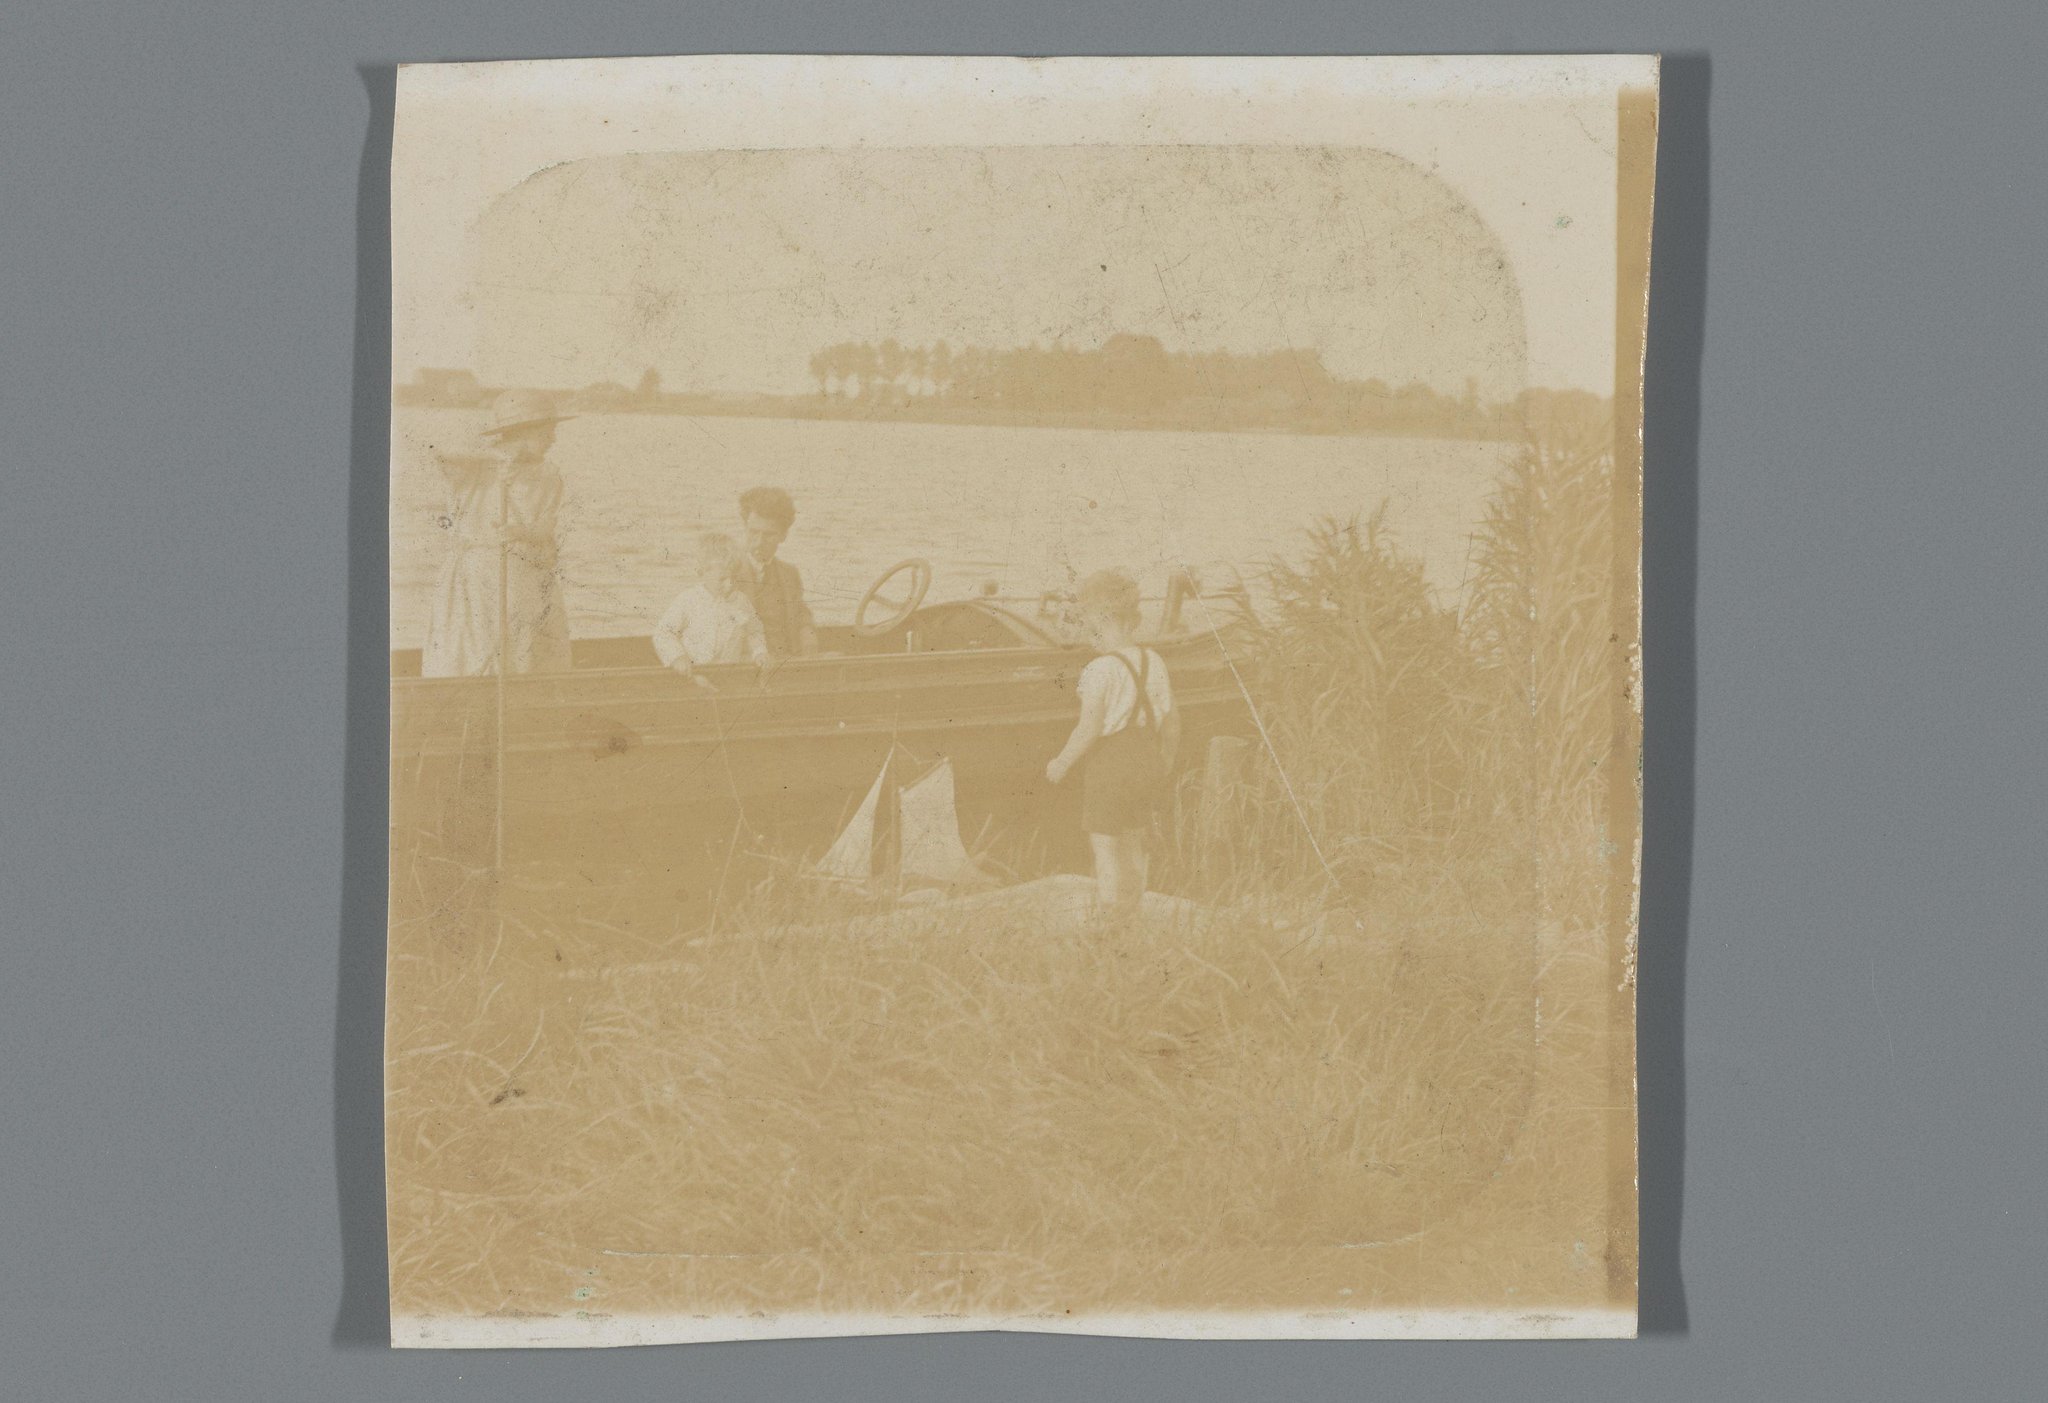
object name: stereograph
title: Gezin bij een boot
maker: Anonymous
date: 1890-1930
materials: paper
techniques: gelatin silver print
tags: family life, steamship, motorship